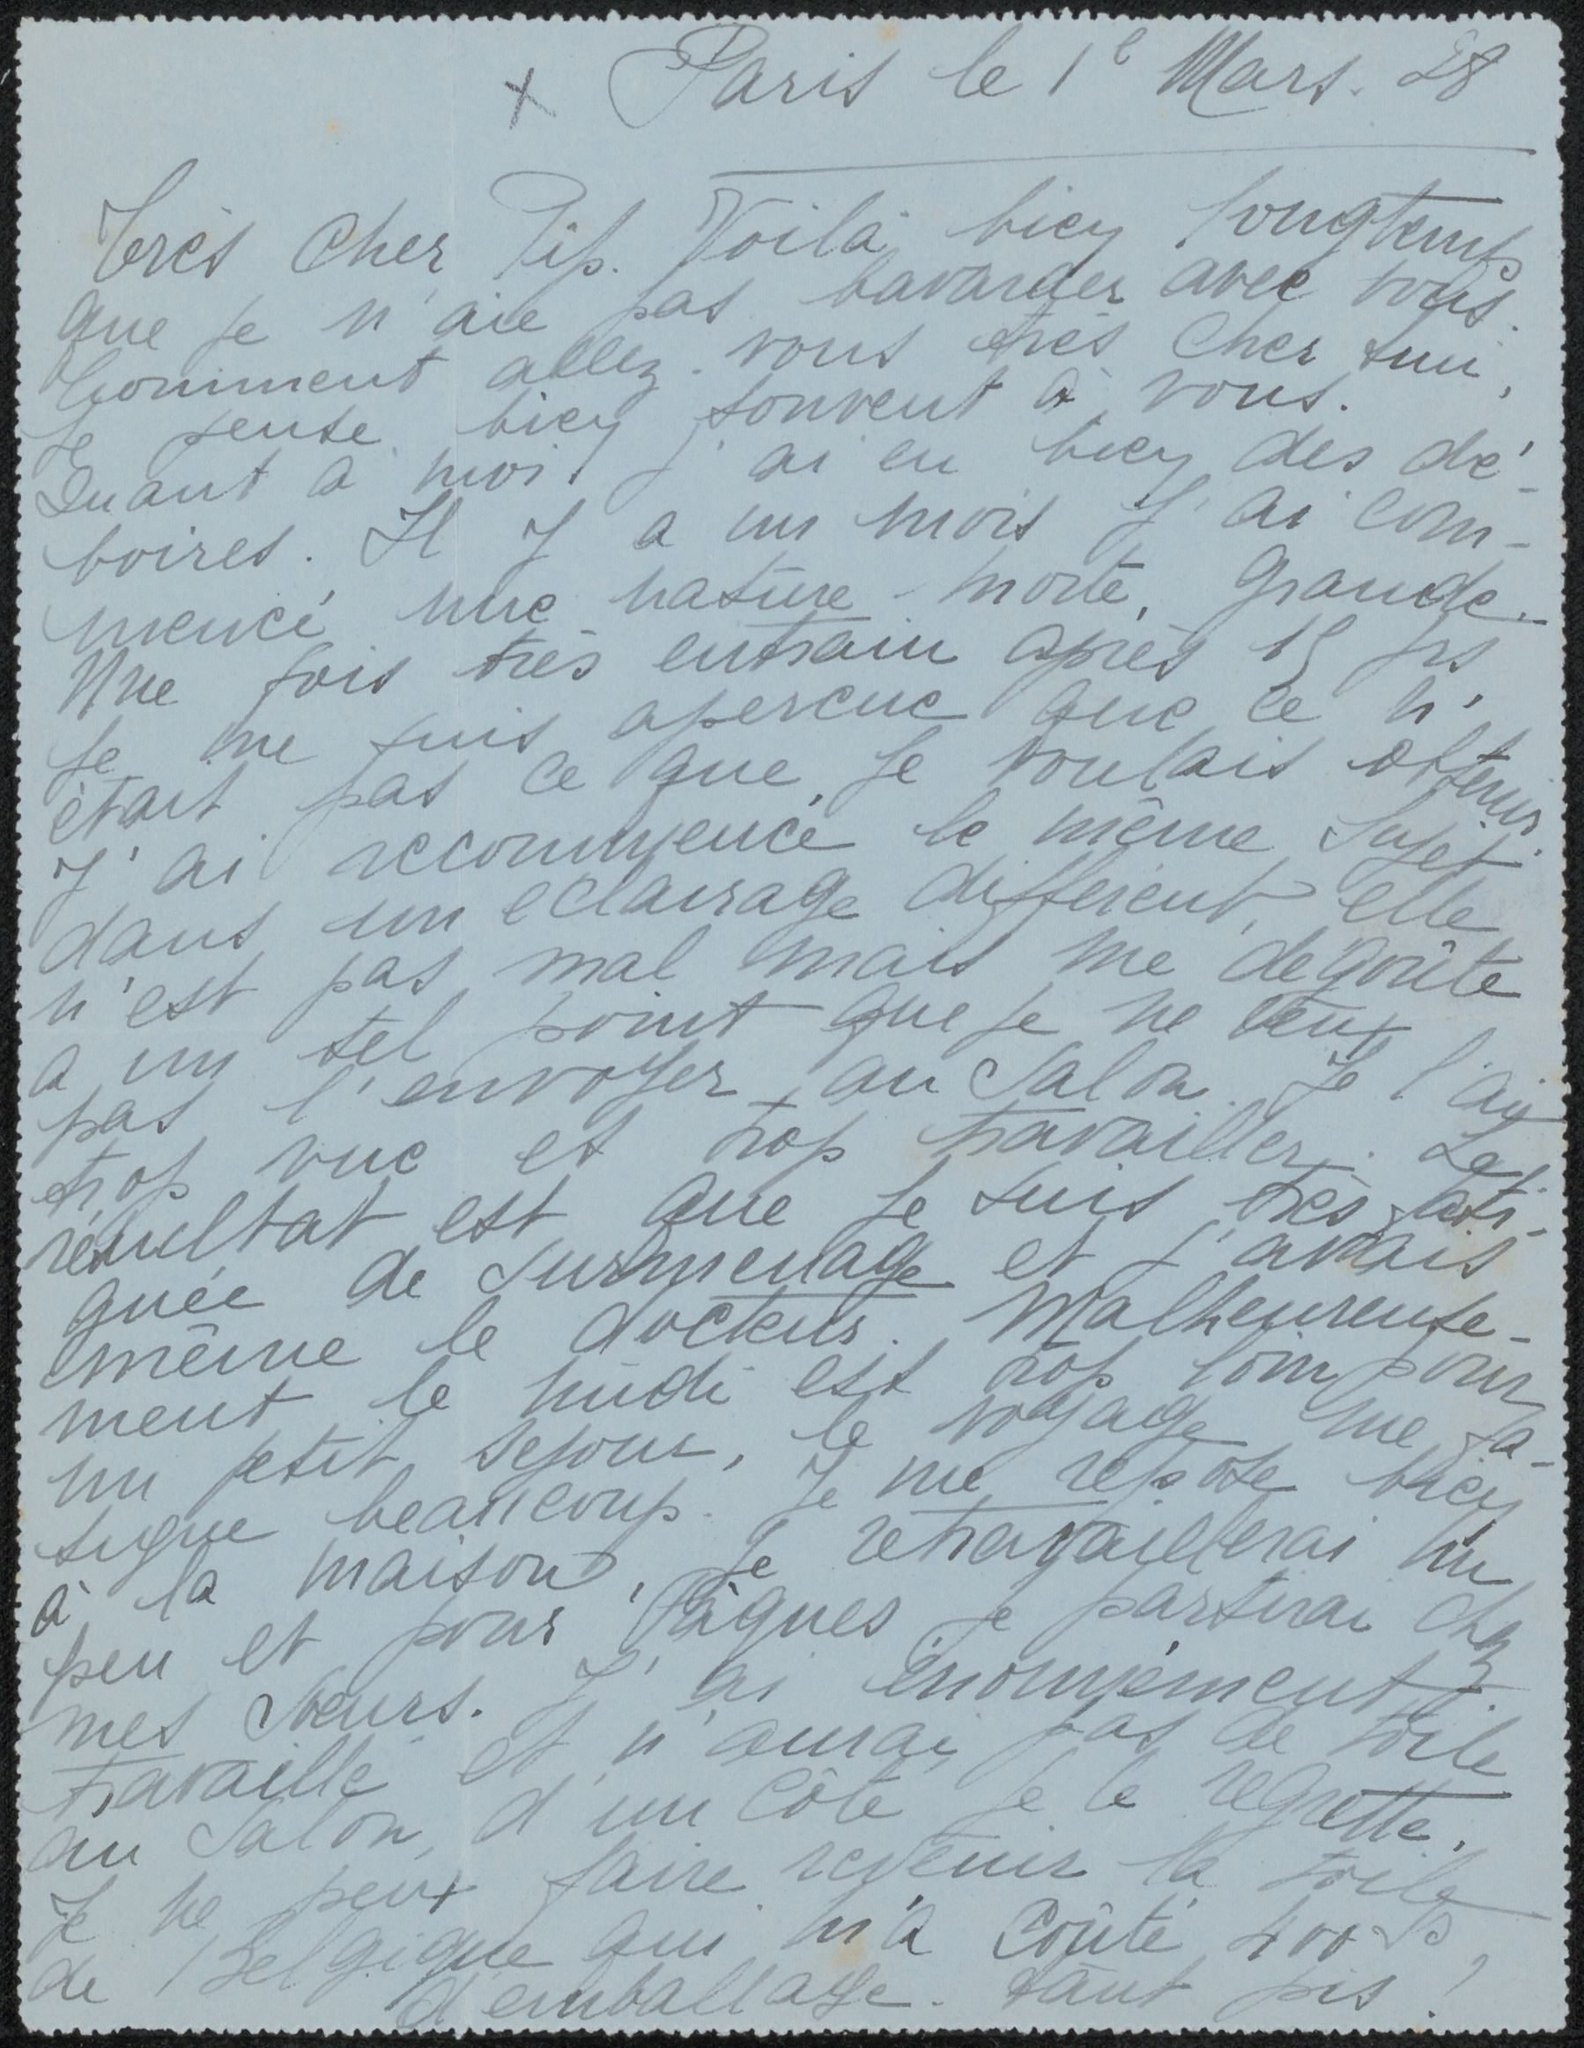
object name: letter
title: Brief aan Philip Zilcken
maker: rose imel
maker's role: draughtsman, painter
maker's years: 1901-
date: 1928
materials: ink, paper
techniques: pen, writing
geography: paris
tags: painter, draughtsman, philip zilcken, painting (including book-illumination, miniature-painting), exhibition ~ art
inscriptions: collector's mark: ‘RPK’